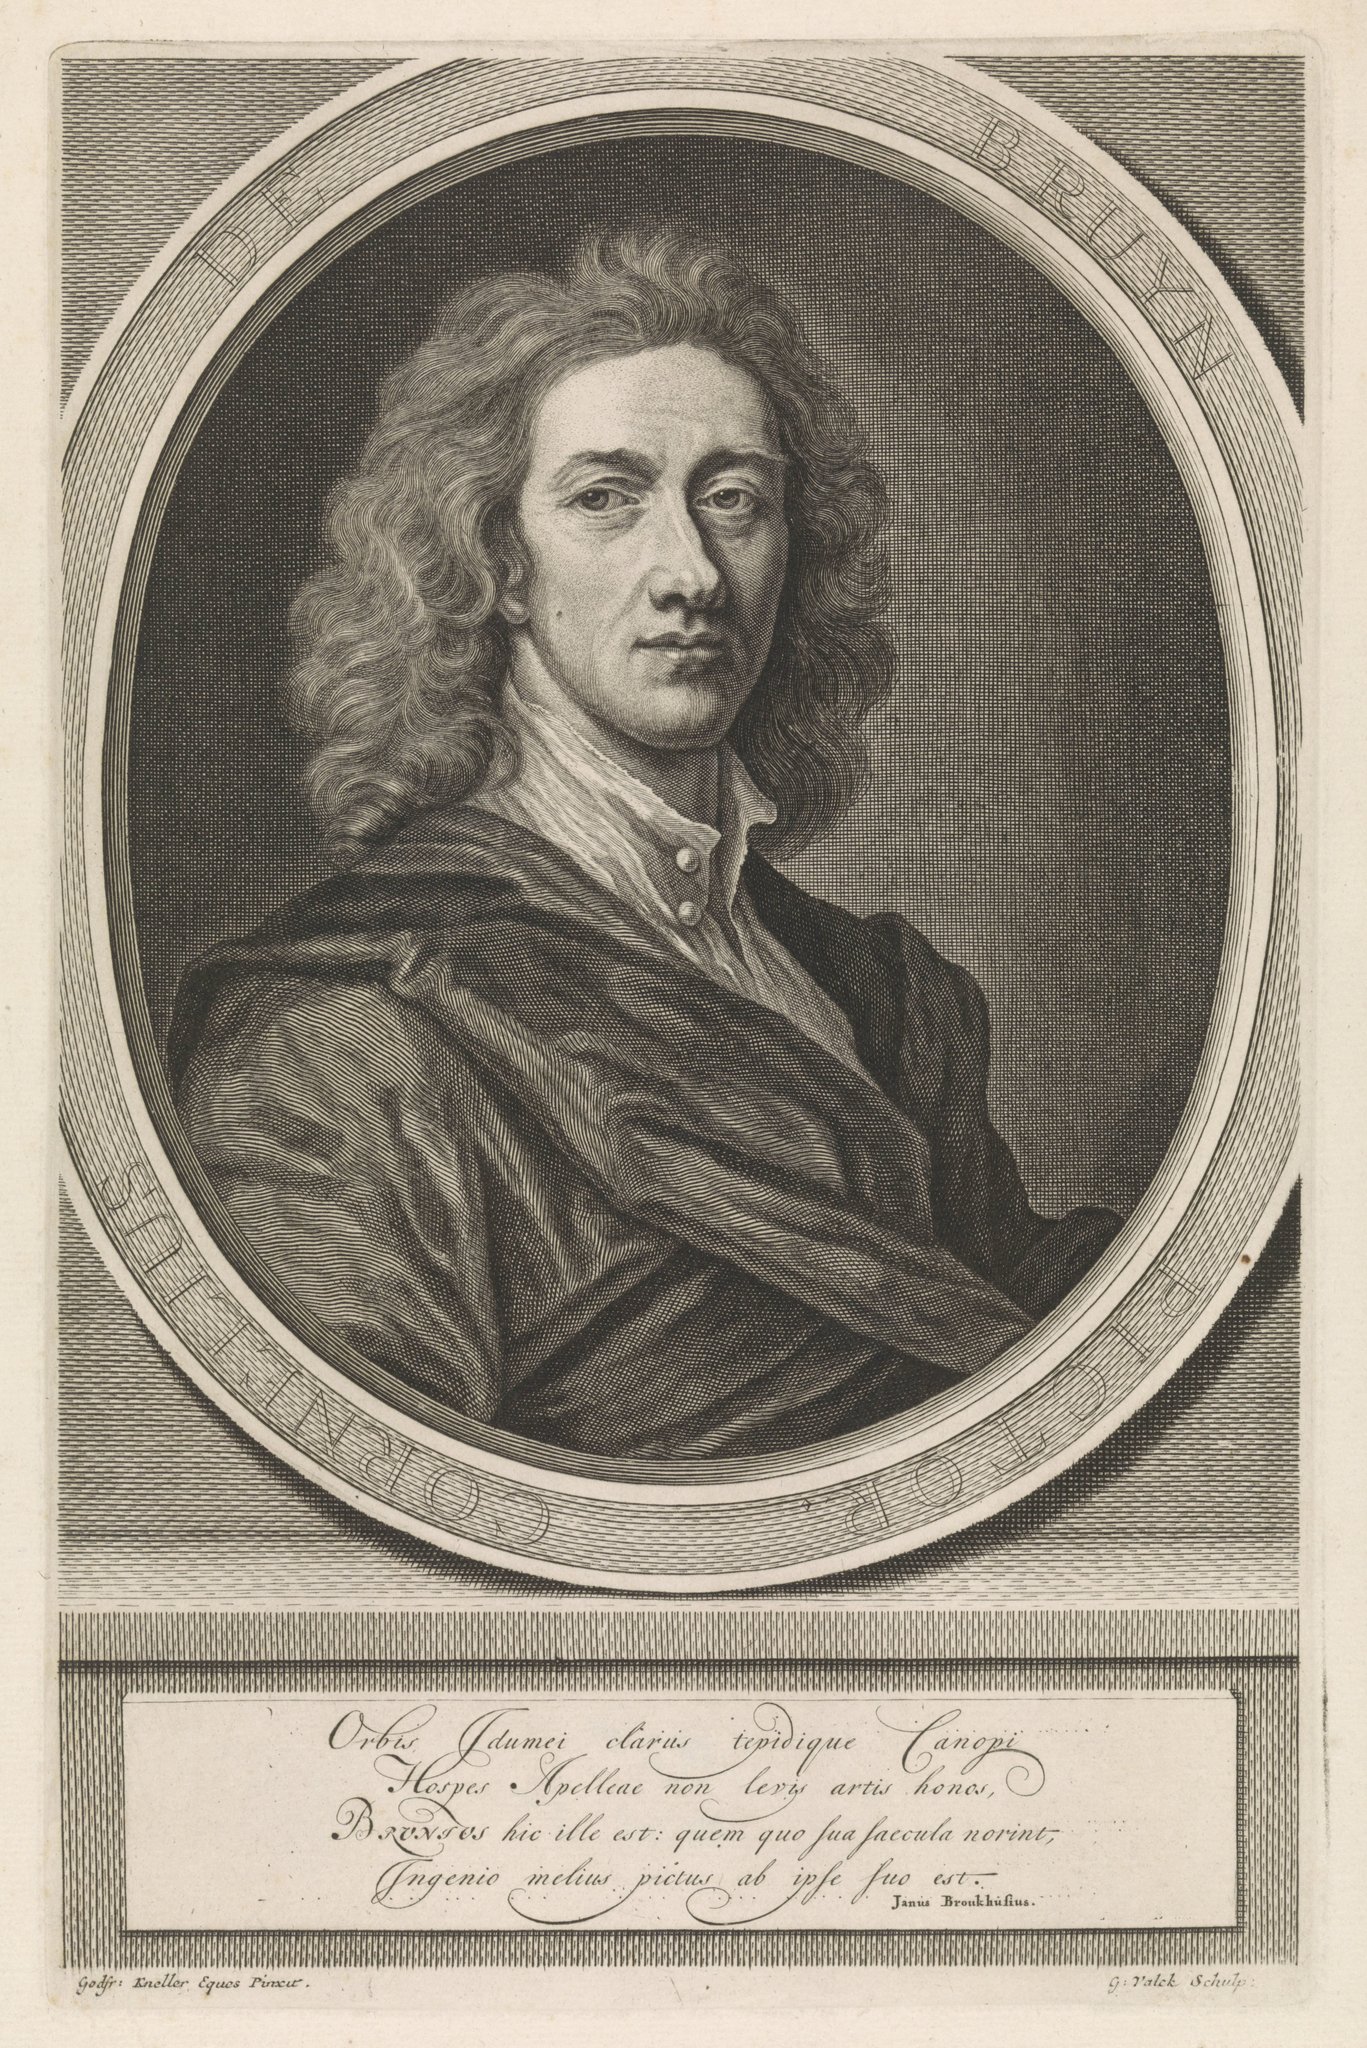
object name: print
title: Portret van de schilder Cornelis de Bruyn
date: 1698-1726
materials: paper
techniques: engraving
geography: amsterdam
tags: the hague, utrecht, draughtsman, cornelis de bruyn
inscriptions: collector's mark: Lugt 2228